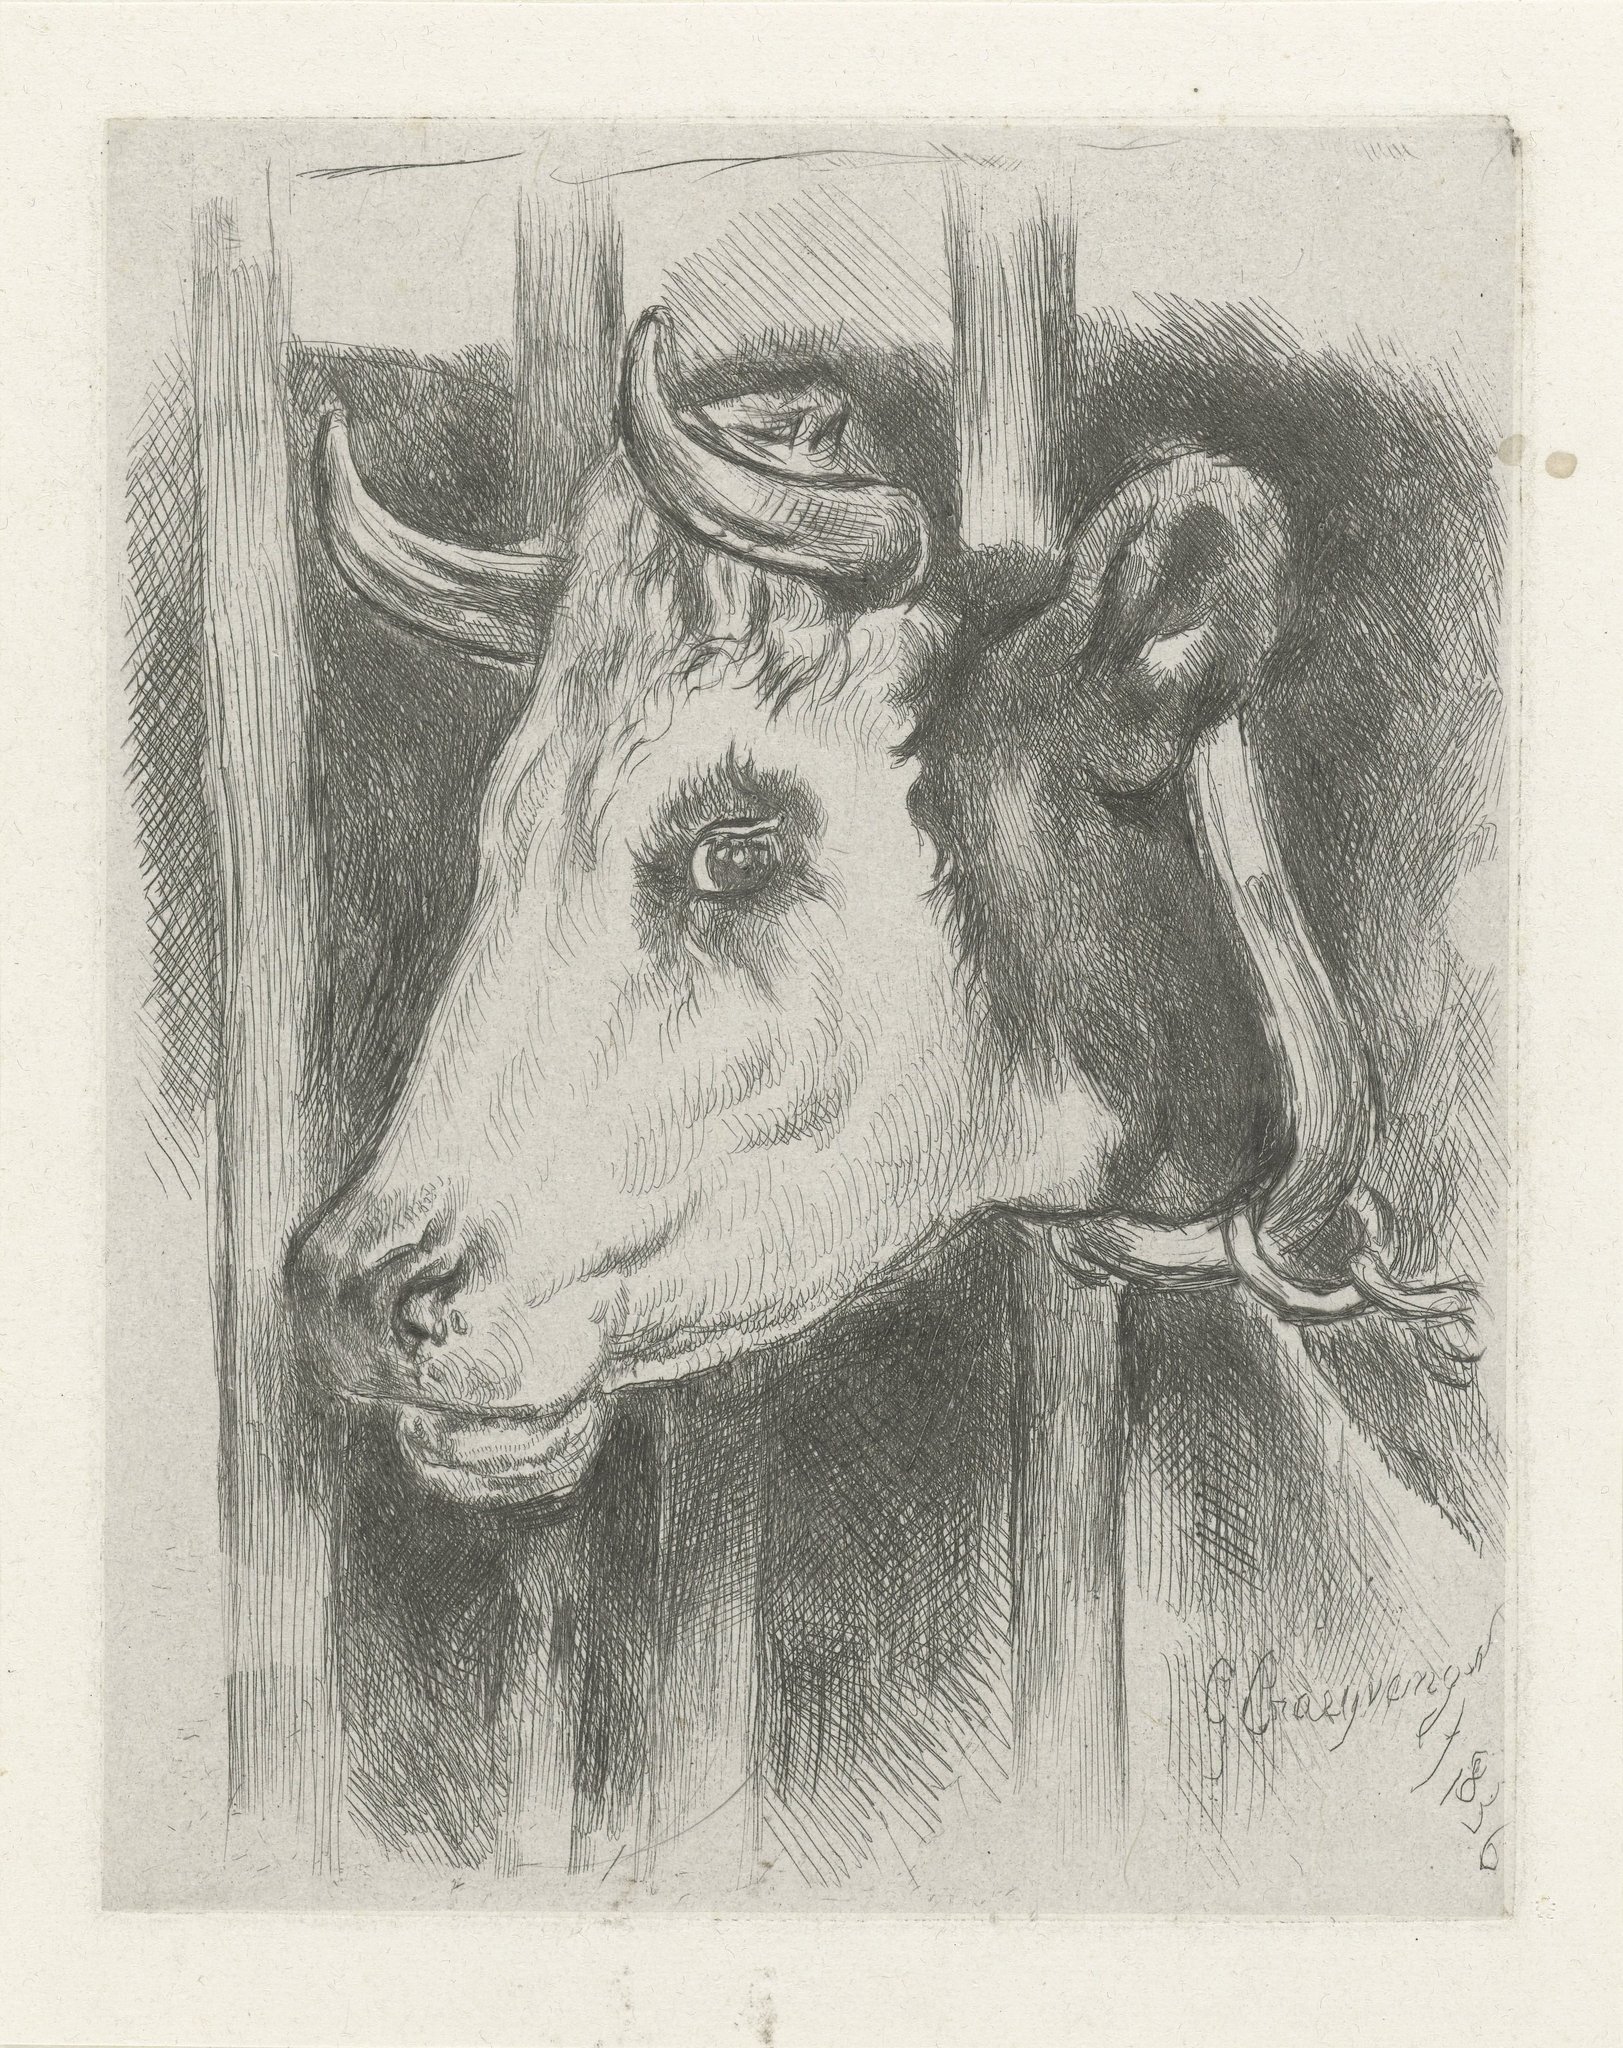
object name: print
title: Kop van een koe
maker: gijsbertus craeyvanger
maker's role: draughtsman, print maker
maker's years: 1810-1895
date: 1836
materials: paper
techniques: drypoint, etching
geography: utrecht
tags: cow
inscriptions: collector's mark: Lugt 2228